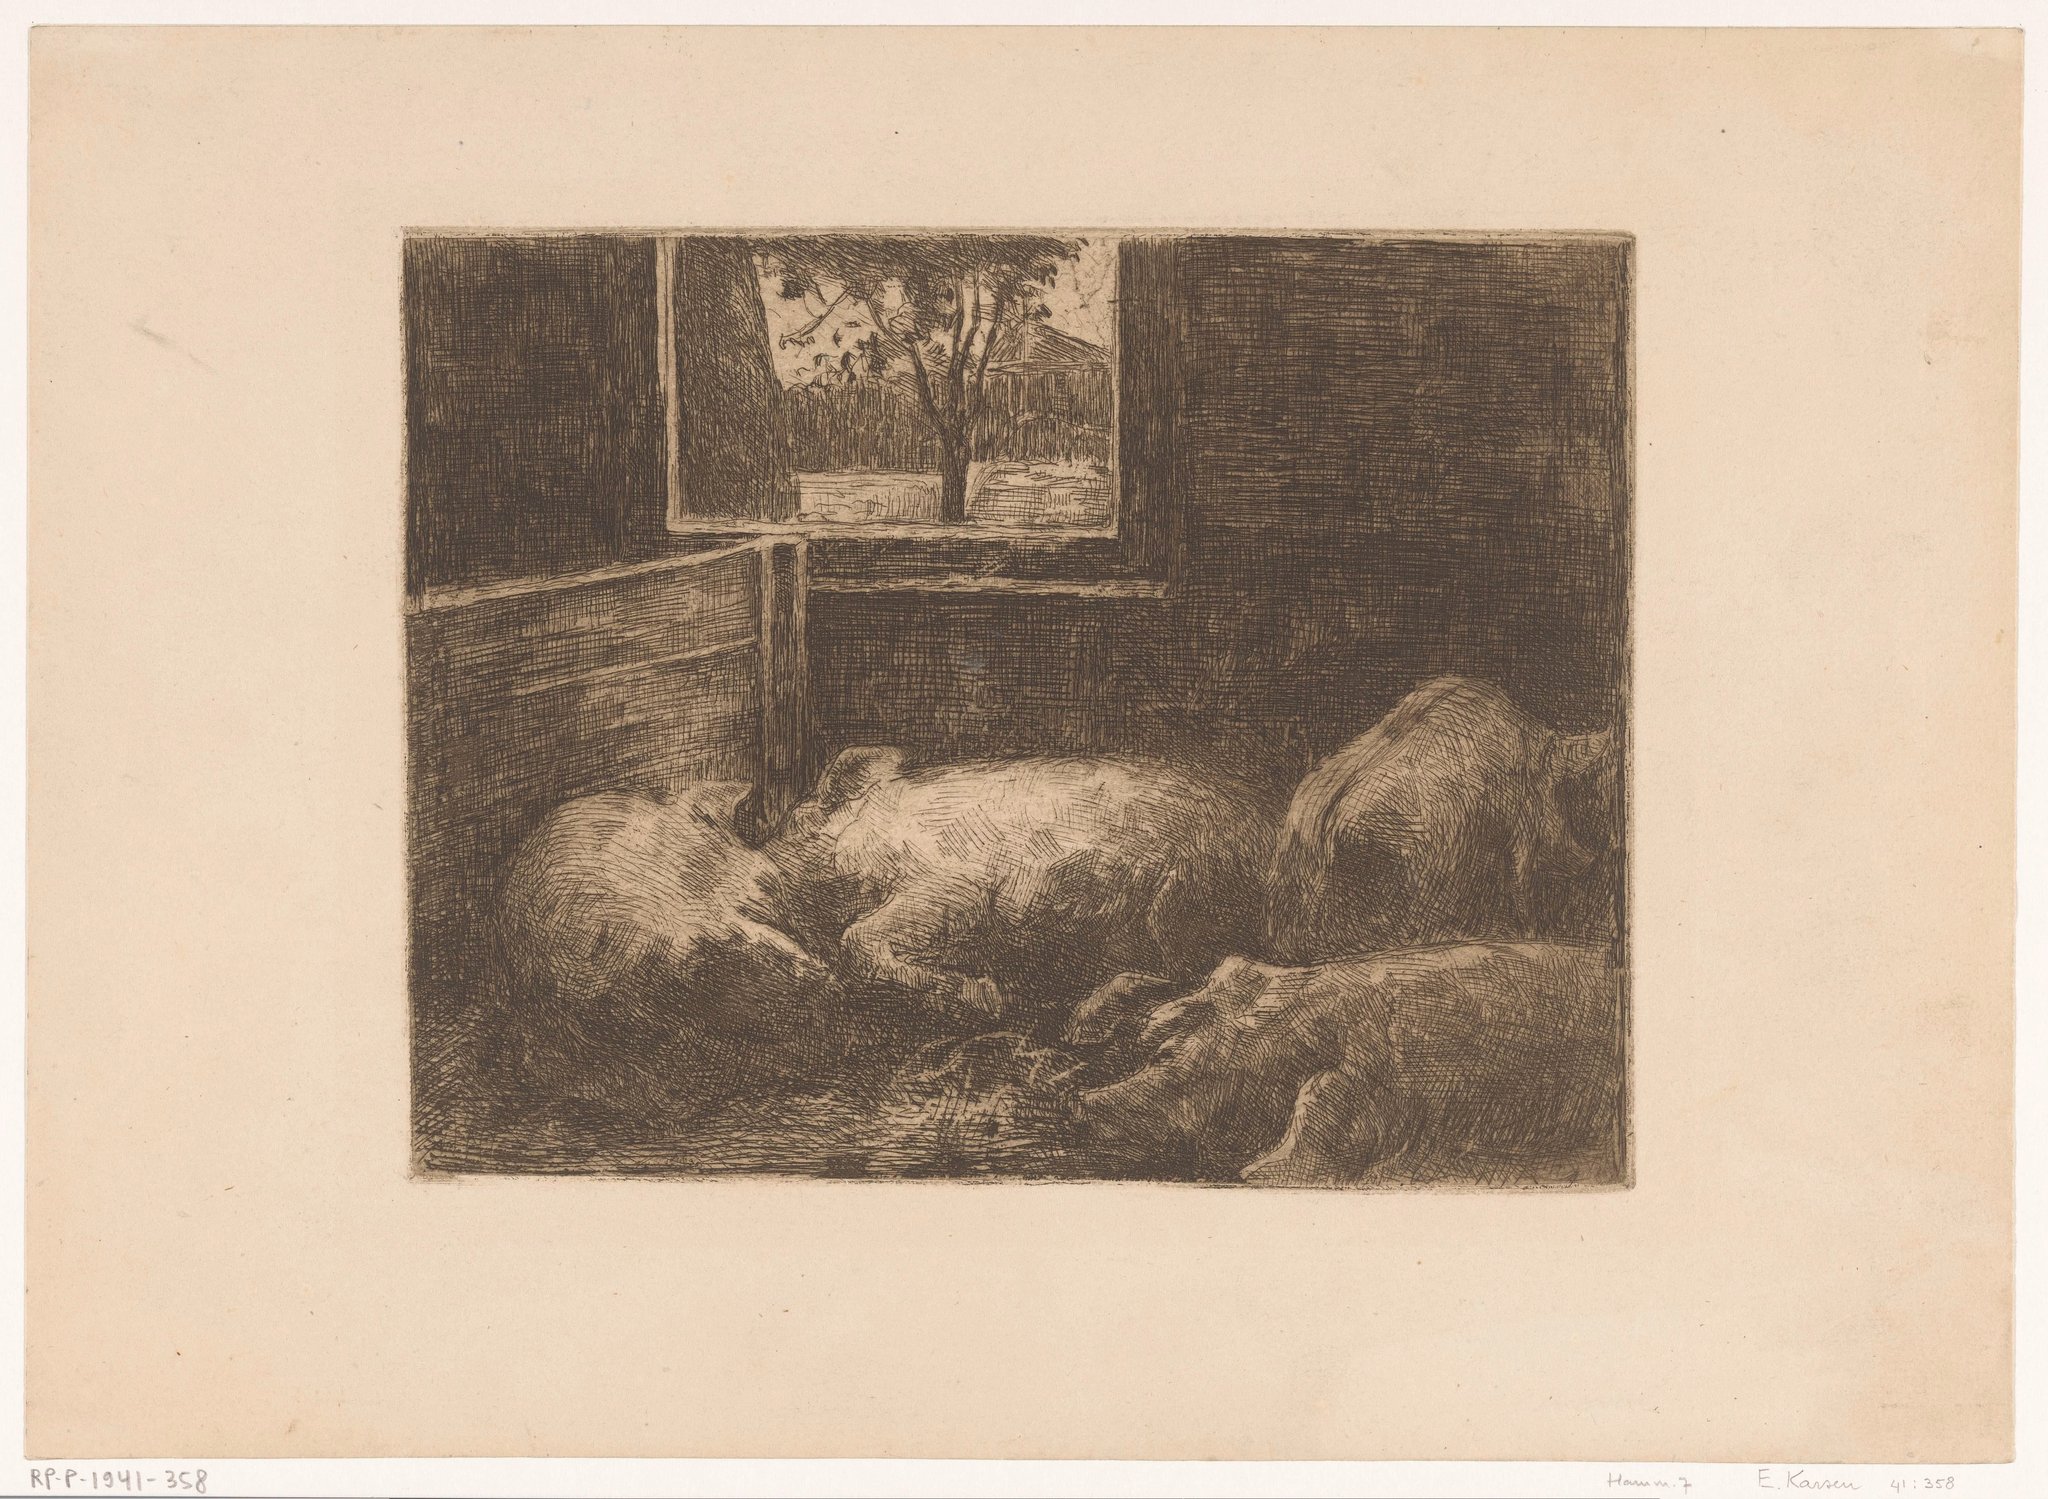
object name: print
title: Varkens in een stal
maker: eduard karsen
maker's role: draughtsman, painter, print maker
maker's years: 1860-1941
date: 1870-1941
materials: paper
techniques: etching, intaglio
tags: pig, stall, stable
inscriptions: collector's mark: Lugt 2228, collector's mark: Lugt 2760